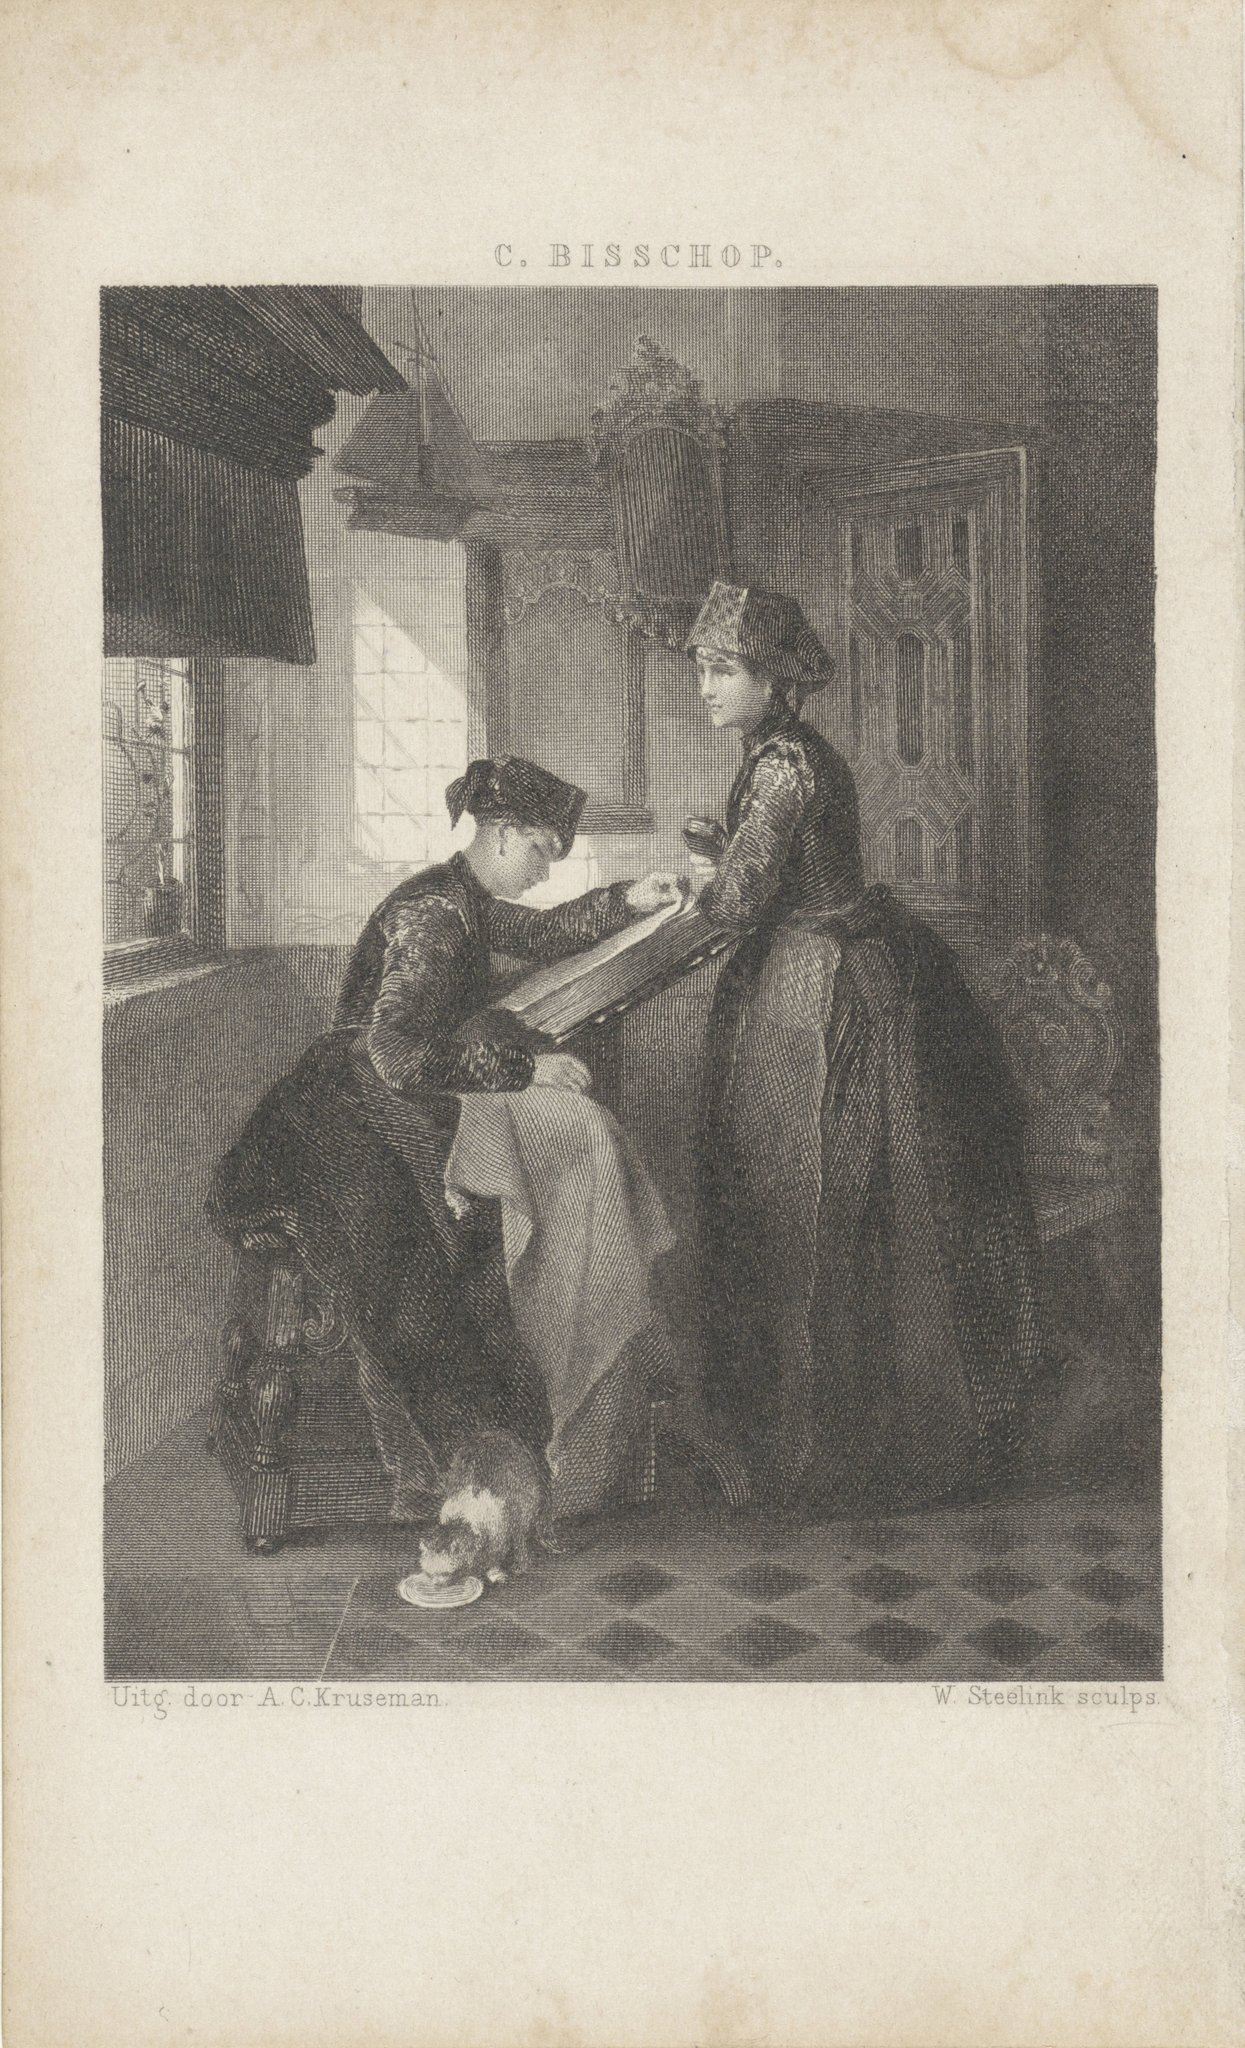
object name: print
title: Twee vrouwen bij een lessenaar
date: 1862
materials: paper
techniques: etching, engraving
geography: haarlem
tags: window, lectern ~ reading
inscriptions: collector's mark: Lugt 2228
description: Interieur met een vrouw die zit te lezen aan een lessenaar. Aan haar voeten drinkt een poes van een schoteltje. Een tweede vrouw staat bij de lessenaar en kijkt uit het raam.